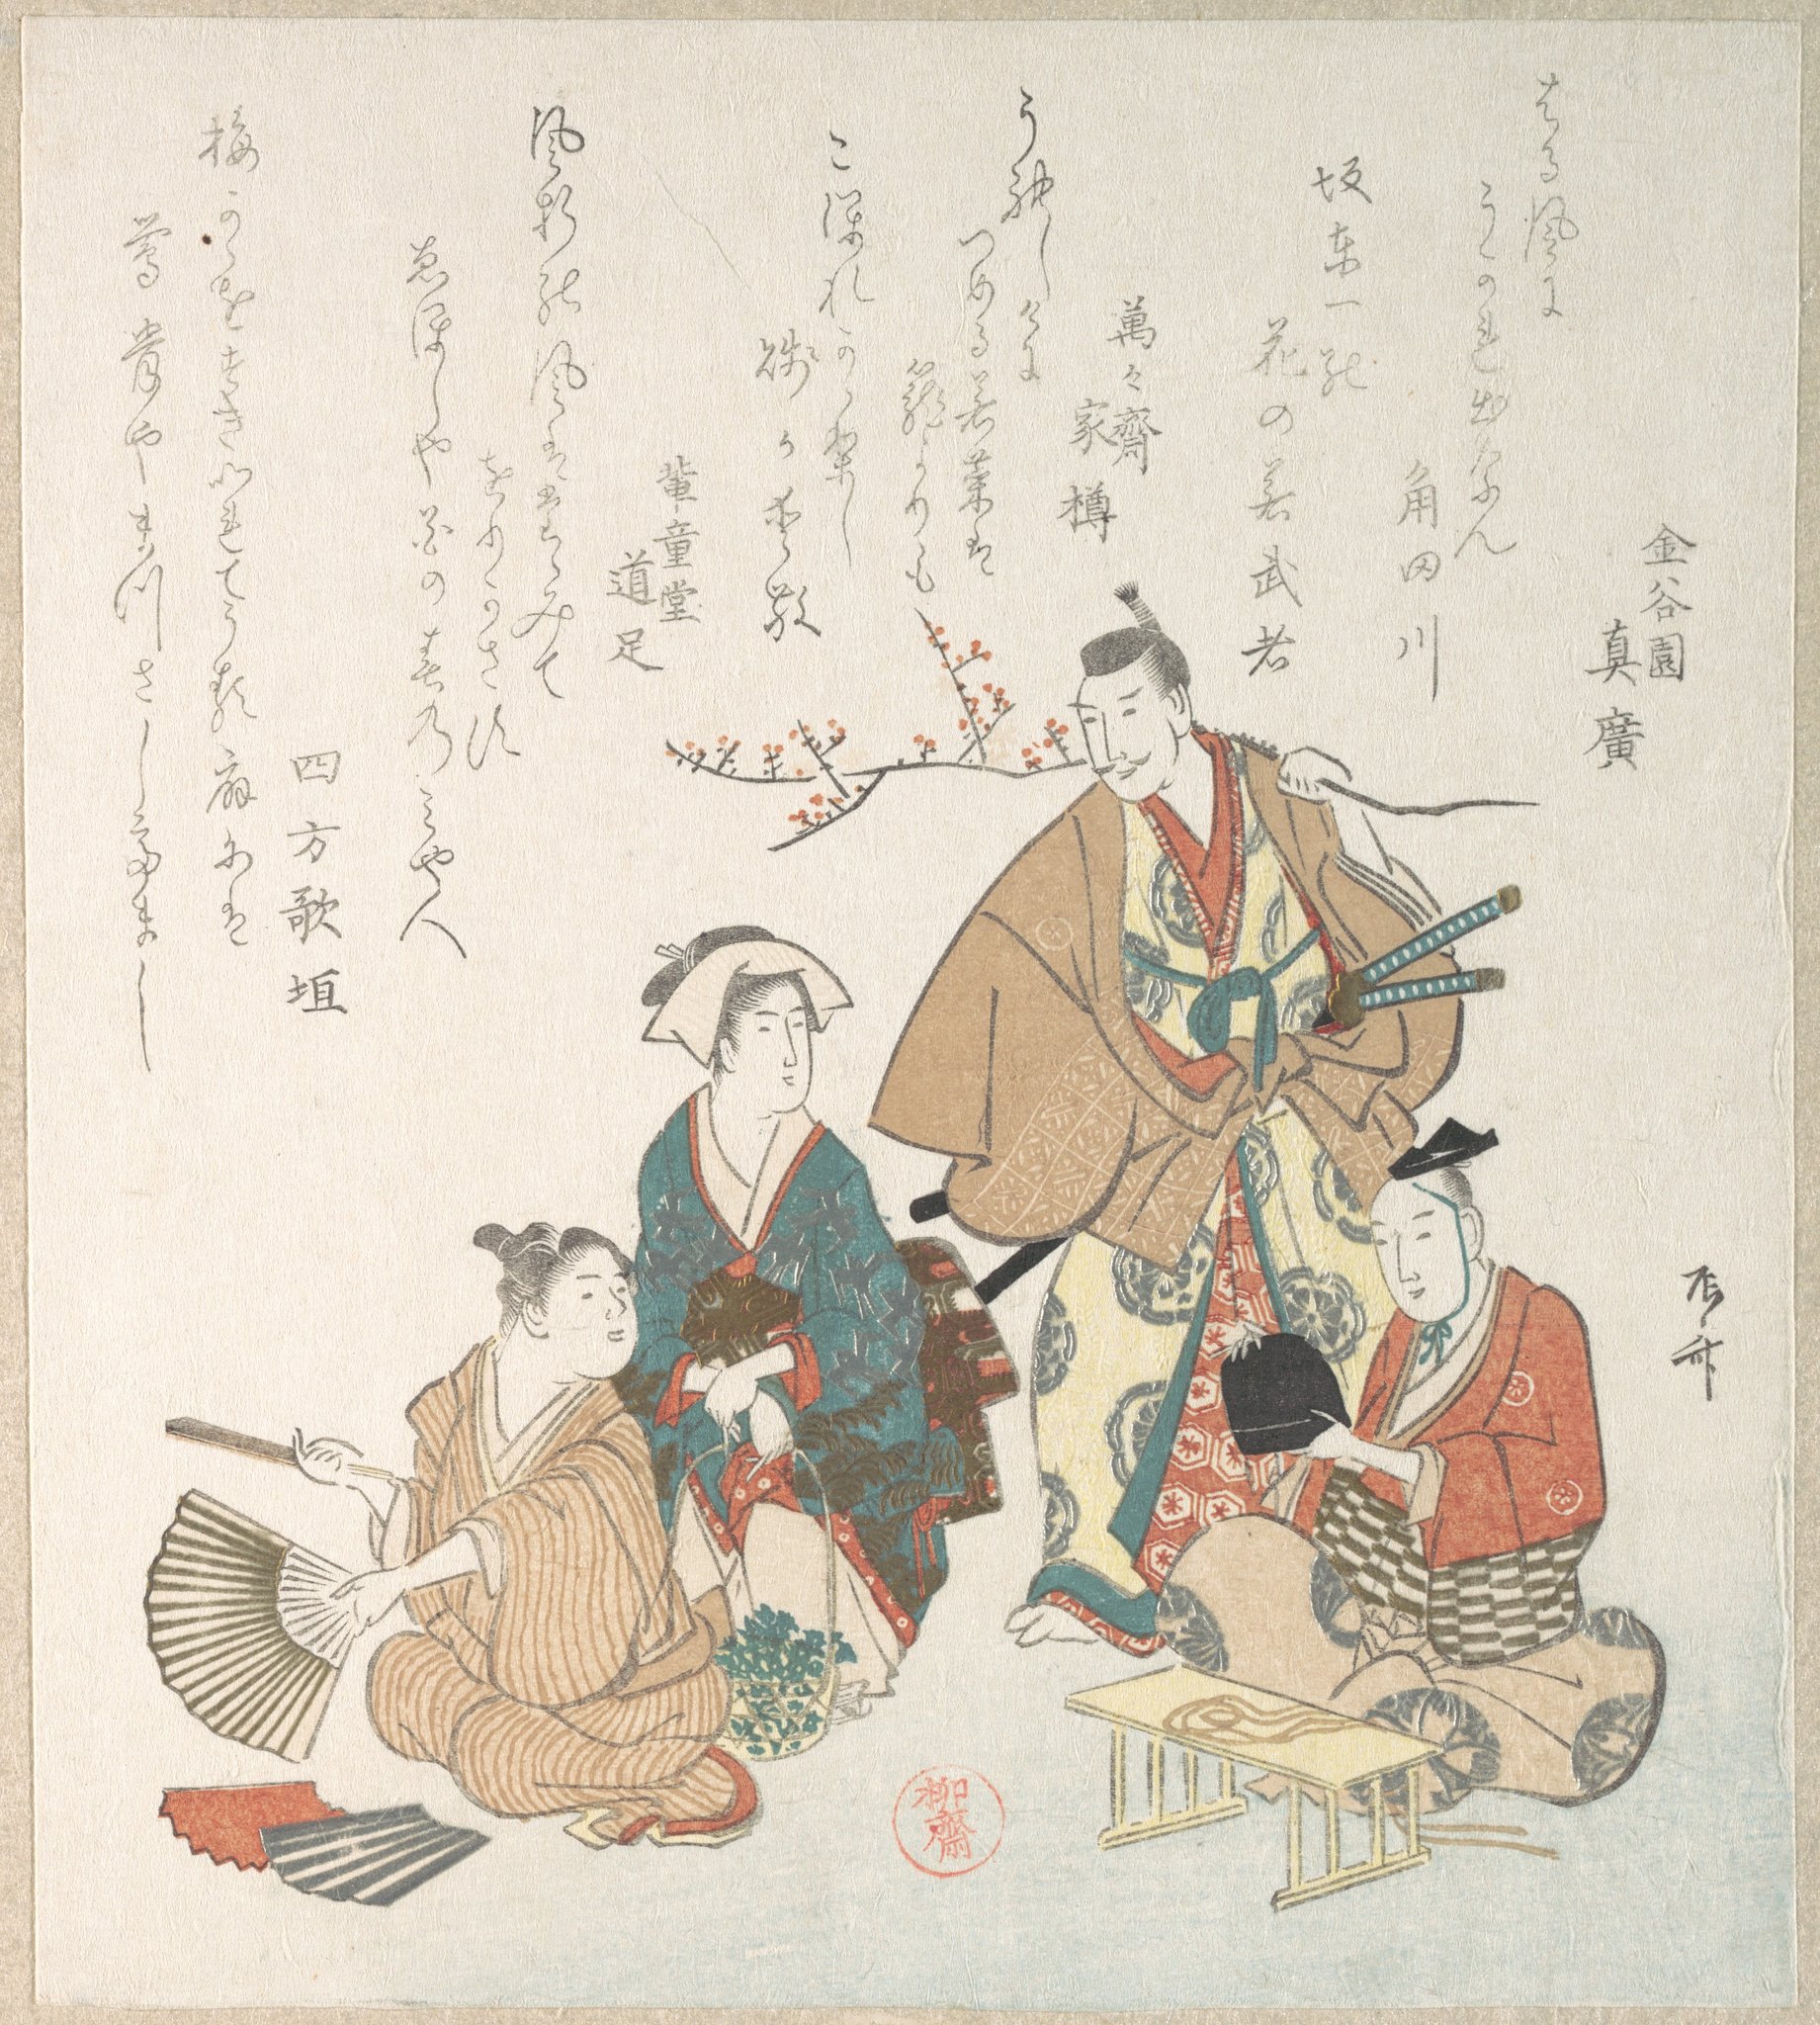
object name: print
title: Street Scene in the Springtime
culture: japanese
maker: ryūryūkyo shinsai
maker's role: artist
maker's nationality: japanese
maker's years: 1799-1823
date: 1801-1900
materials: ink, paper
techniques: surimono, woodblock print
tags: fans,swords,men,women